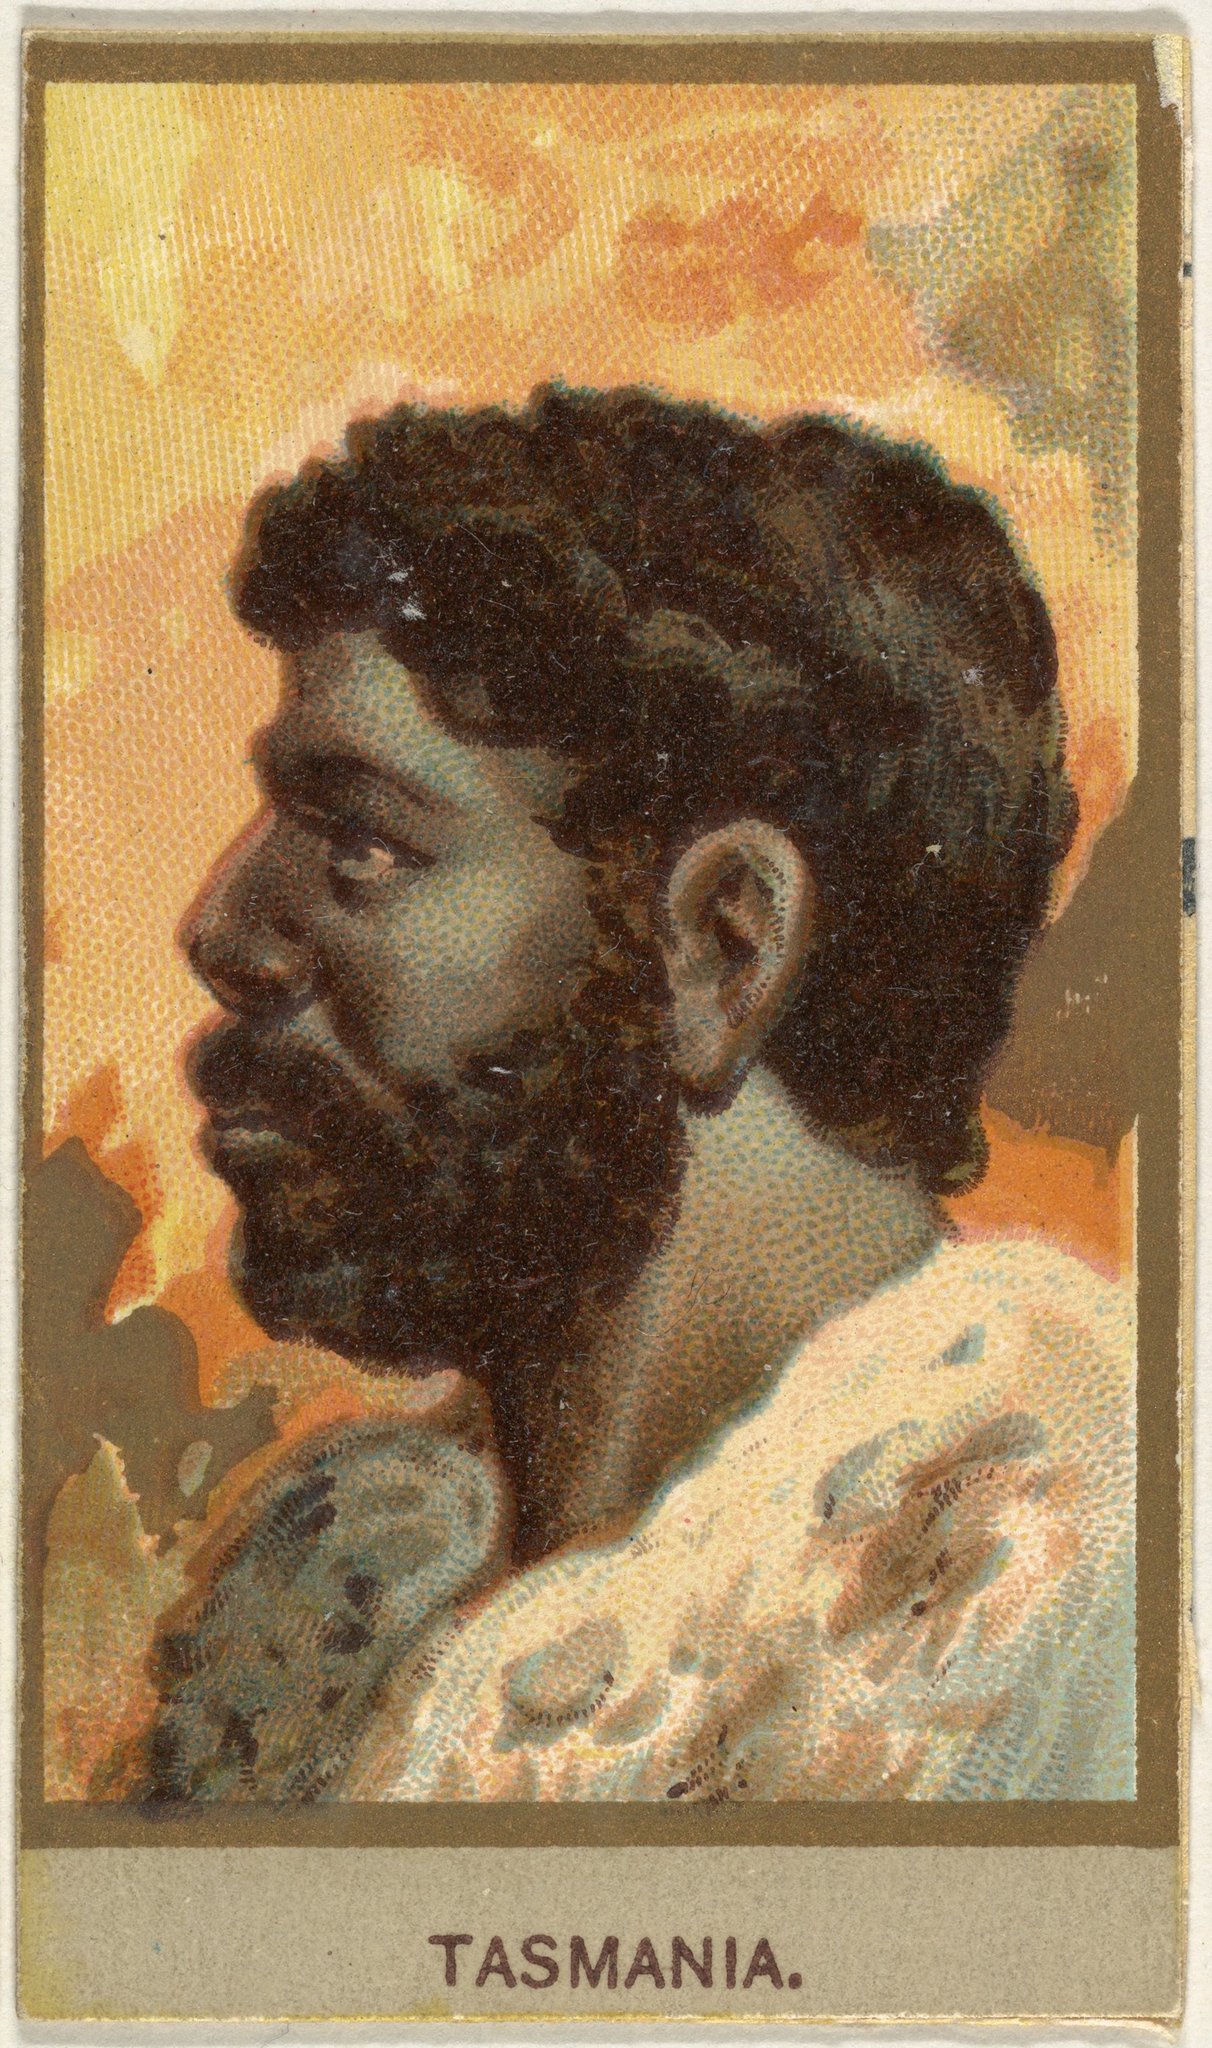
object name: print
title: Tasmania, from the Races of Mankind series (T181) issued by Abdul Cigarettes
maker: abdul cigarettes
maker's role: publisher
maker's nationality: american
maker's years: 1881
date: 1881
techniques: color lithograph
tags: men,profiles